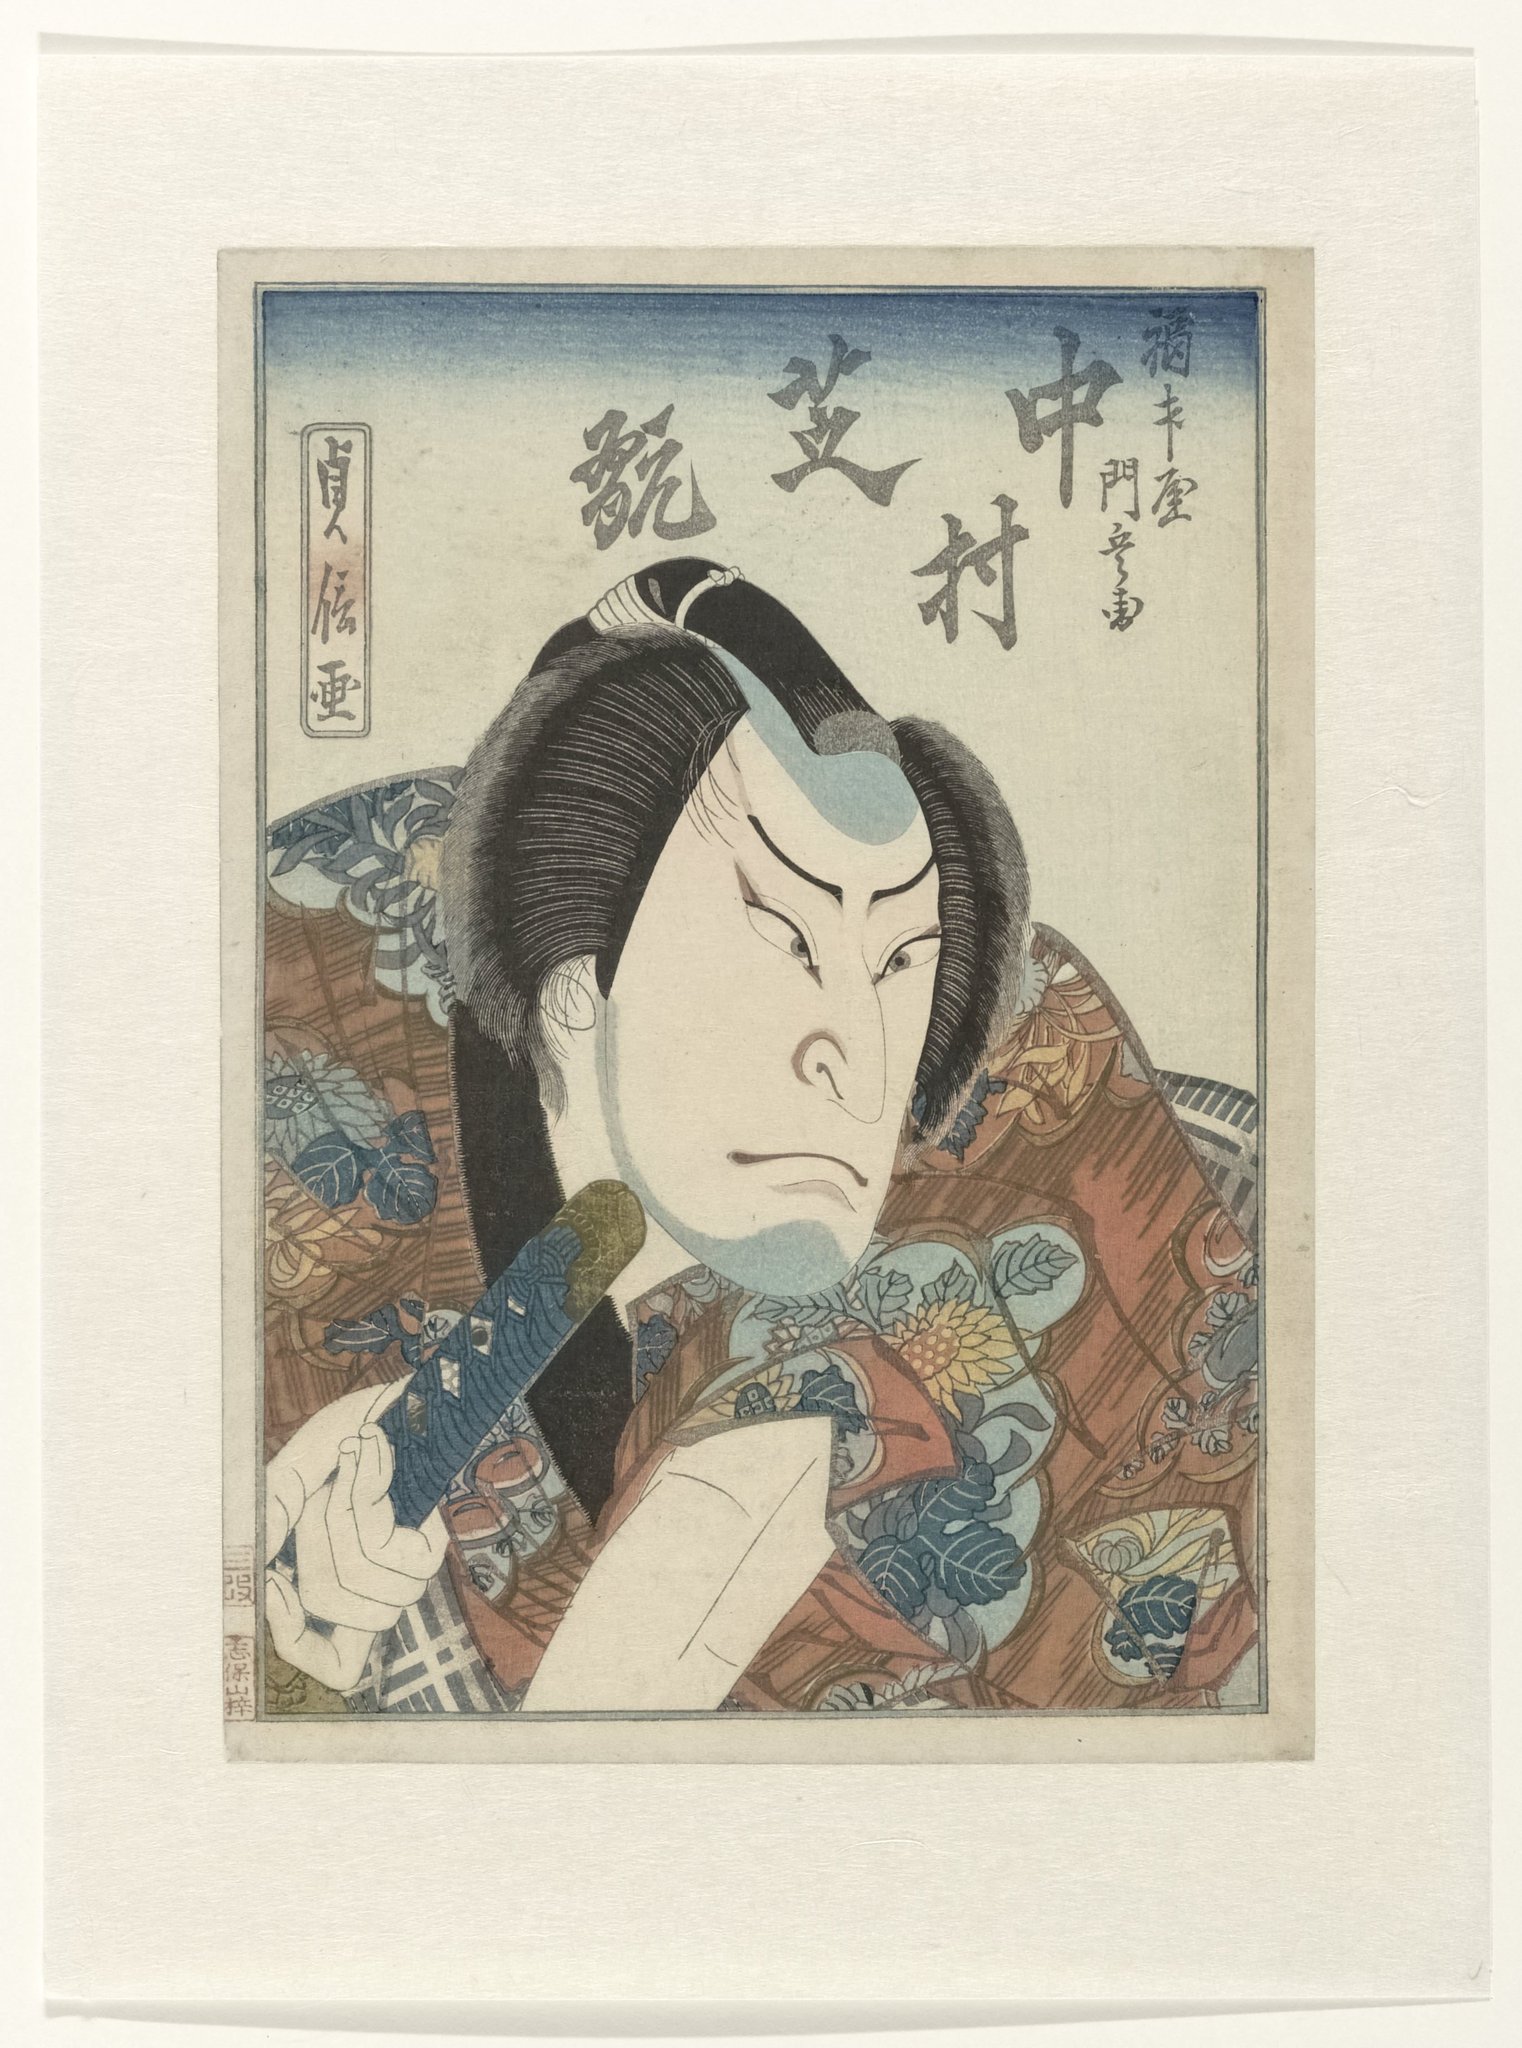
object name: print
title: Nakamura Shikan III als Fukumasuya Monbei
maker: hasegawa sadanobu (i)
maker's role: print maker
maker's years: 1809-1874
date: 1801-1841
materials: paper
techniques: woodcut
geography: osaka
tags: portrait of actor, actress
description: Nakamura Shikan III als Fukumasuya Monbei in het toneelstuk ‘Keisei Yanagizakura’, Naka Theater, januari 1841.